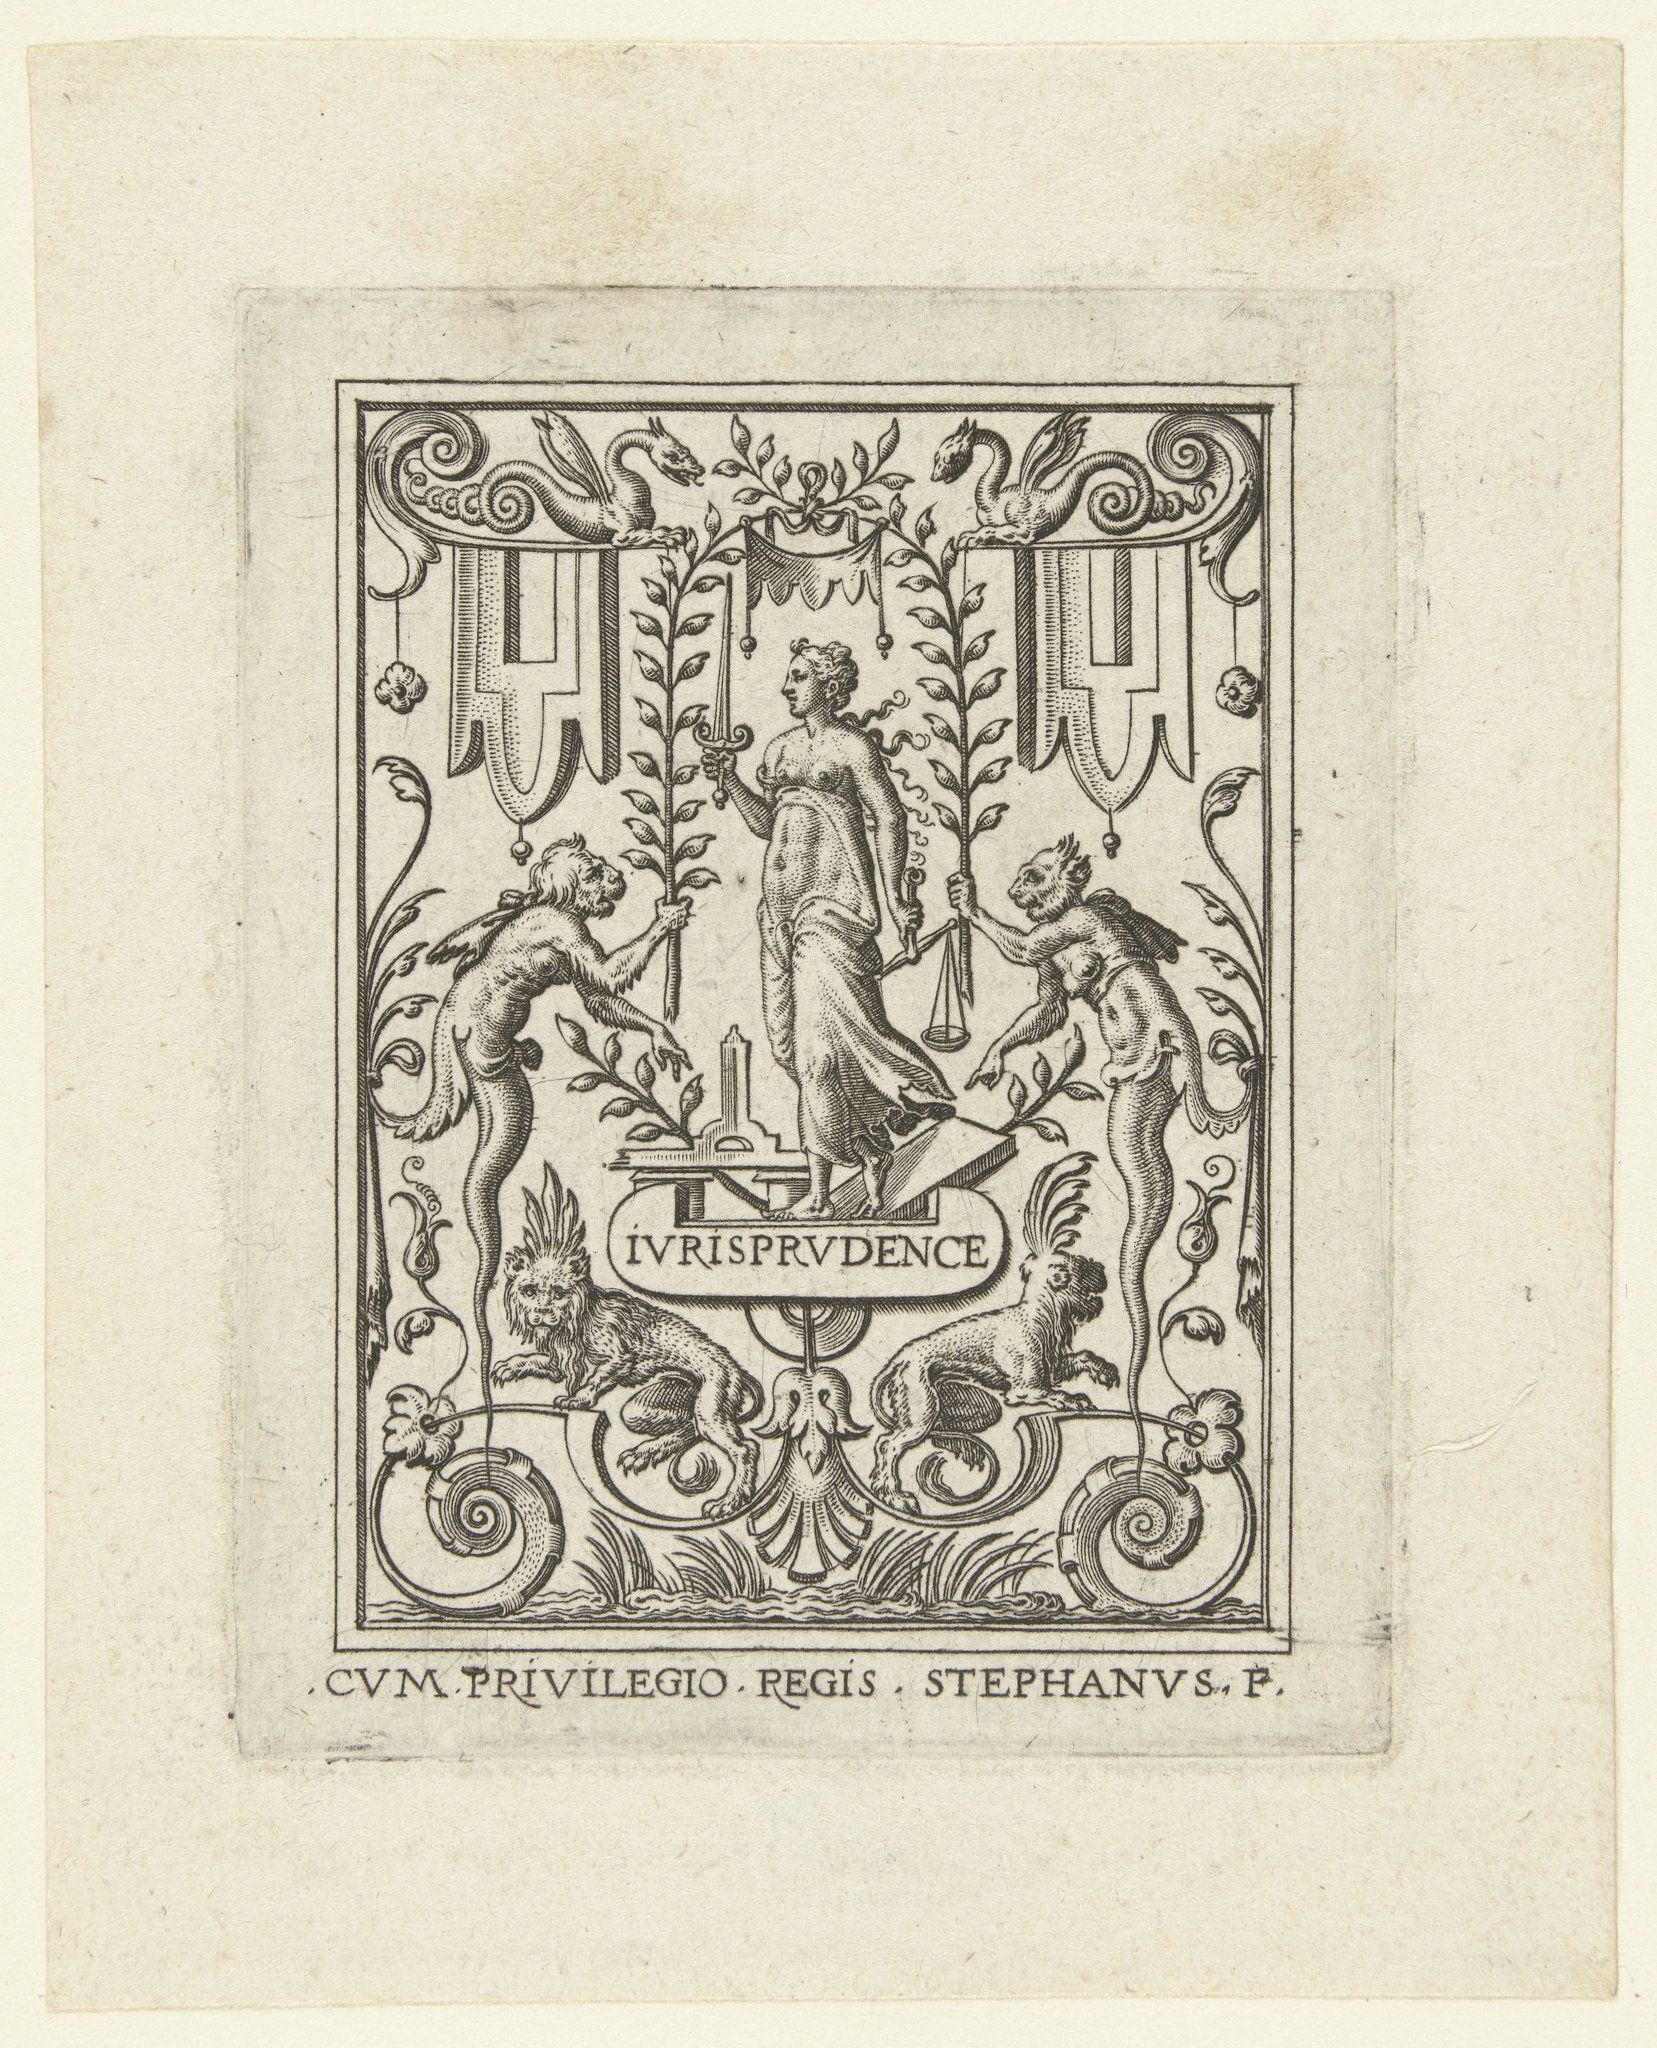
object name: ornament print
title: Jurisprudentie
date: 1528-1583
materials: paper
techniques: engraving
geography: france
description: De Jurisprudentie met een zwaard en een weegschaal onder een boog van bladeren, gevormd door twee takken. Uit serie van 6 bladen.